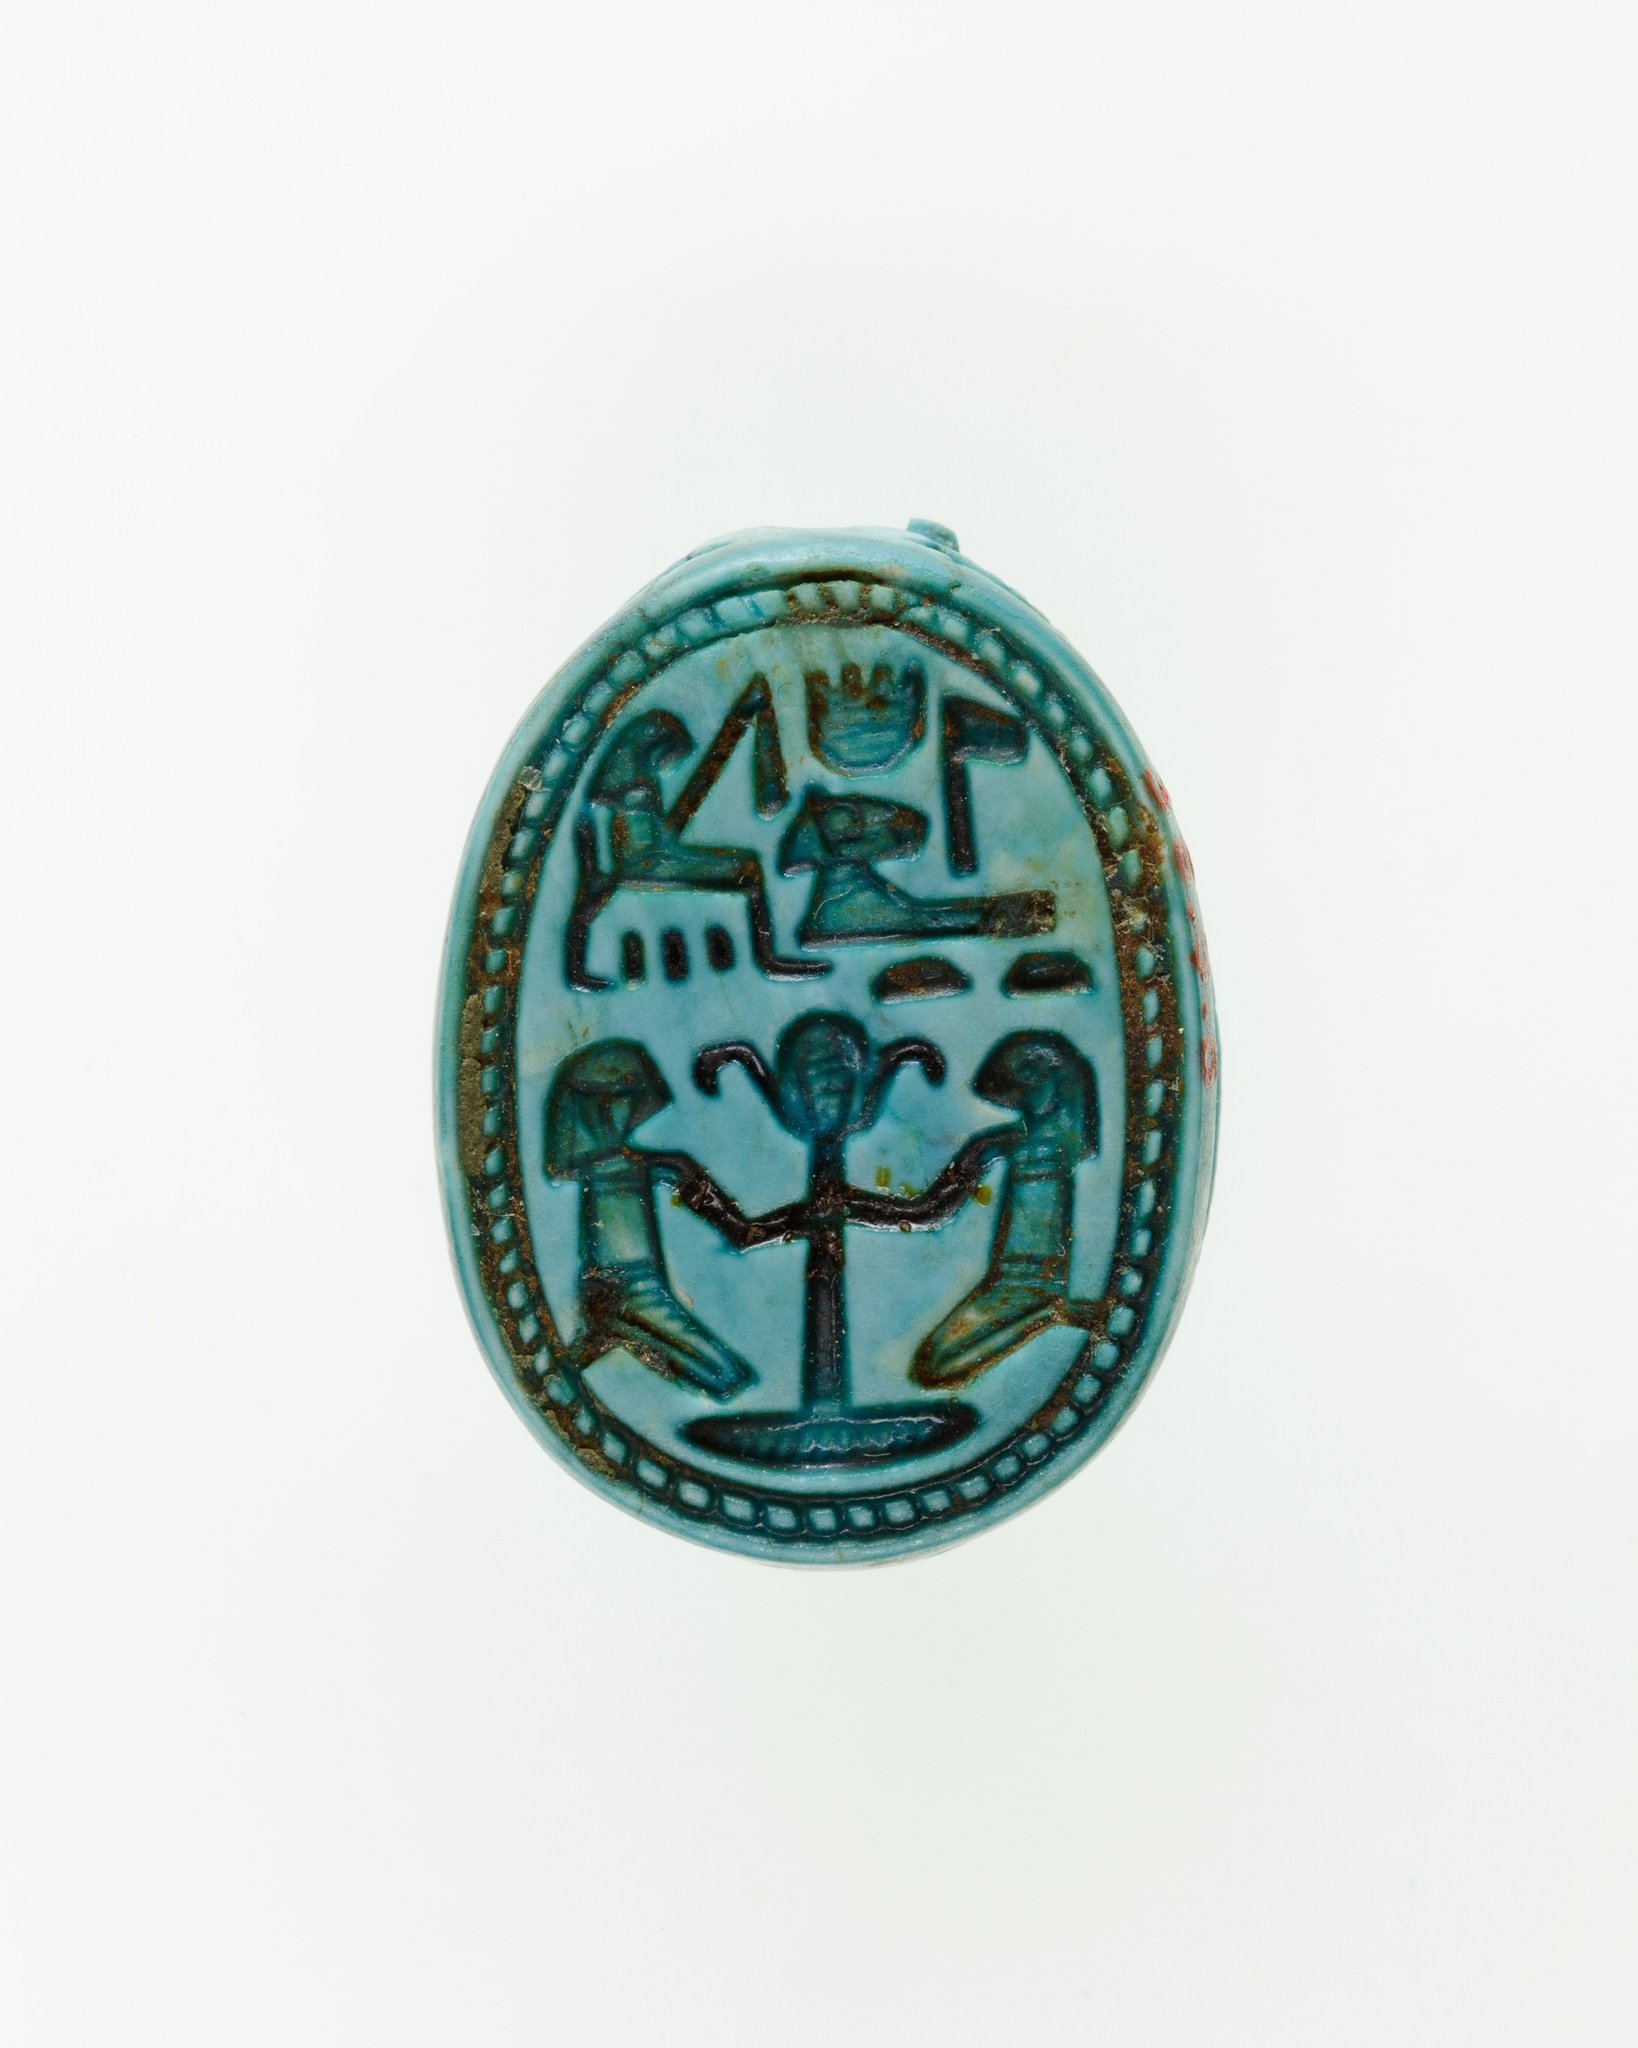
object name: scarab, hatshepsut, hatnefer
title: Scarab of Hatnefer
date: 1492-1473 BCE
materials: stone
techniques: glazing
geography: egypt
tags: hieroglyphs,scarabs